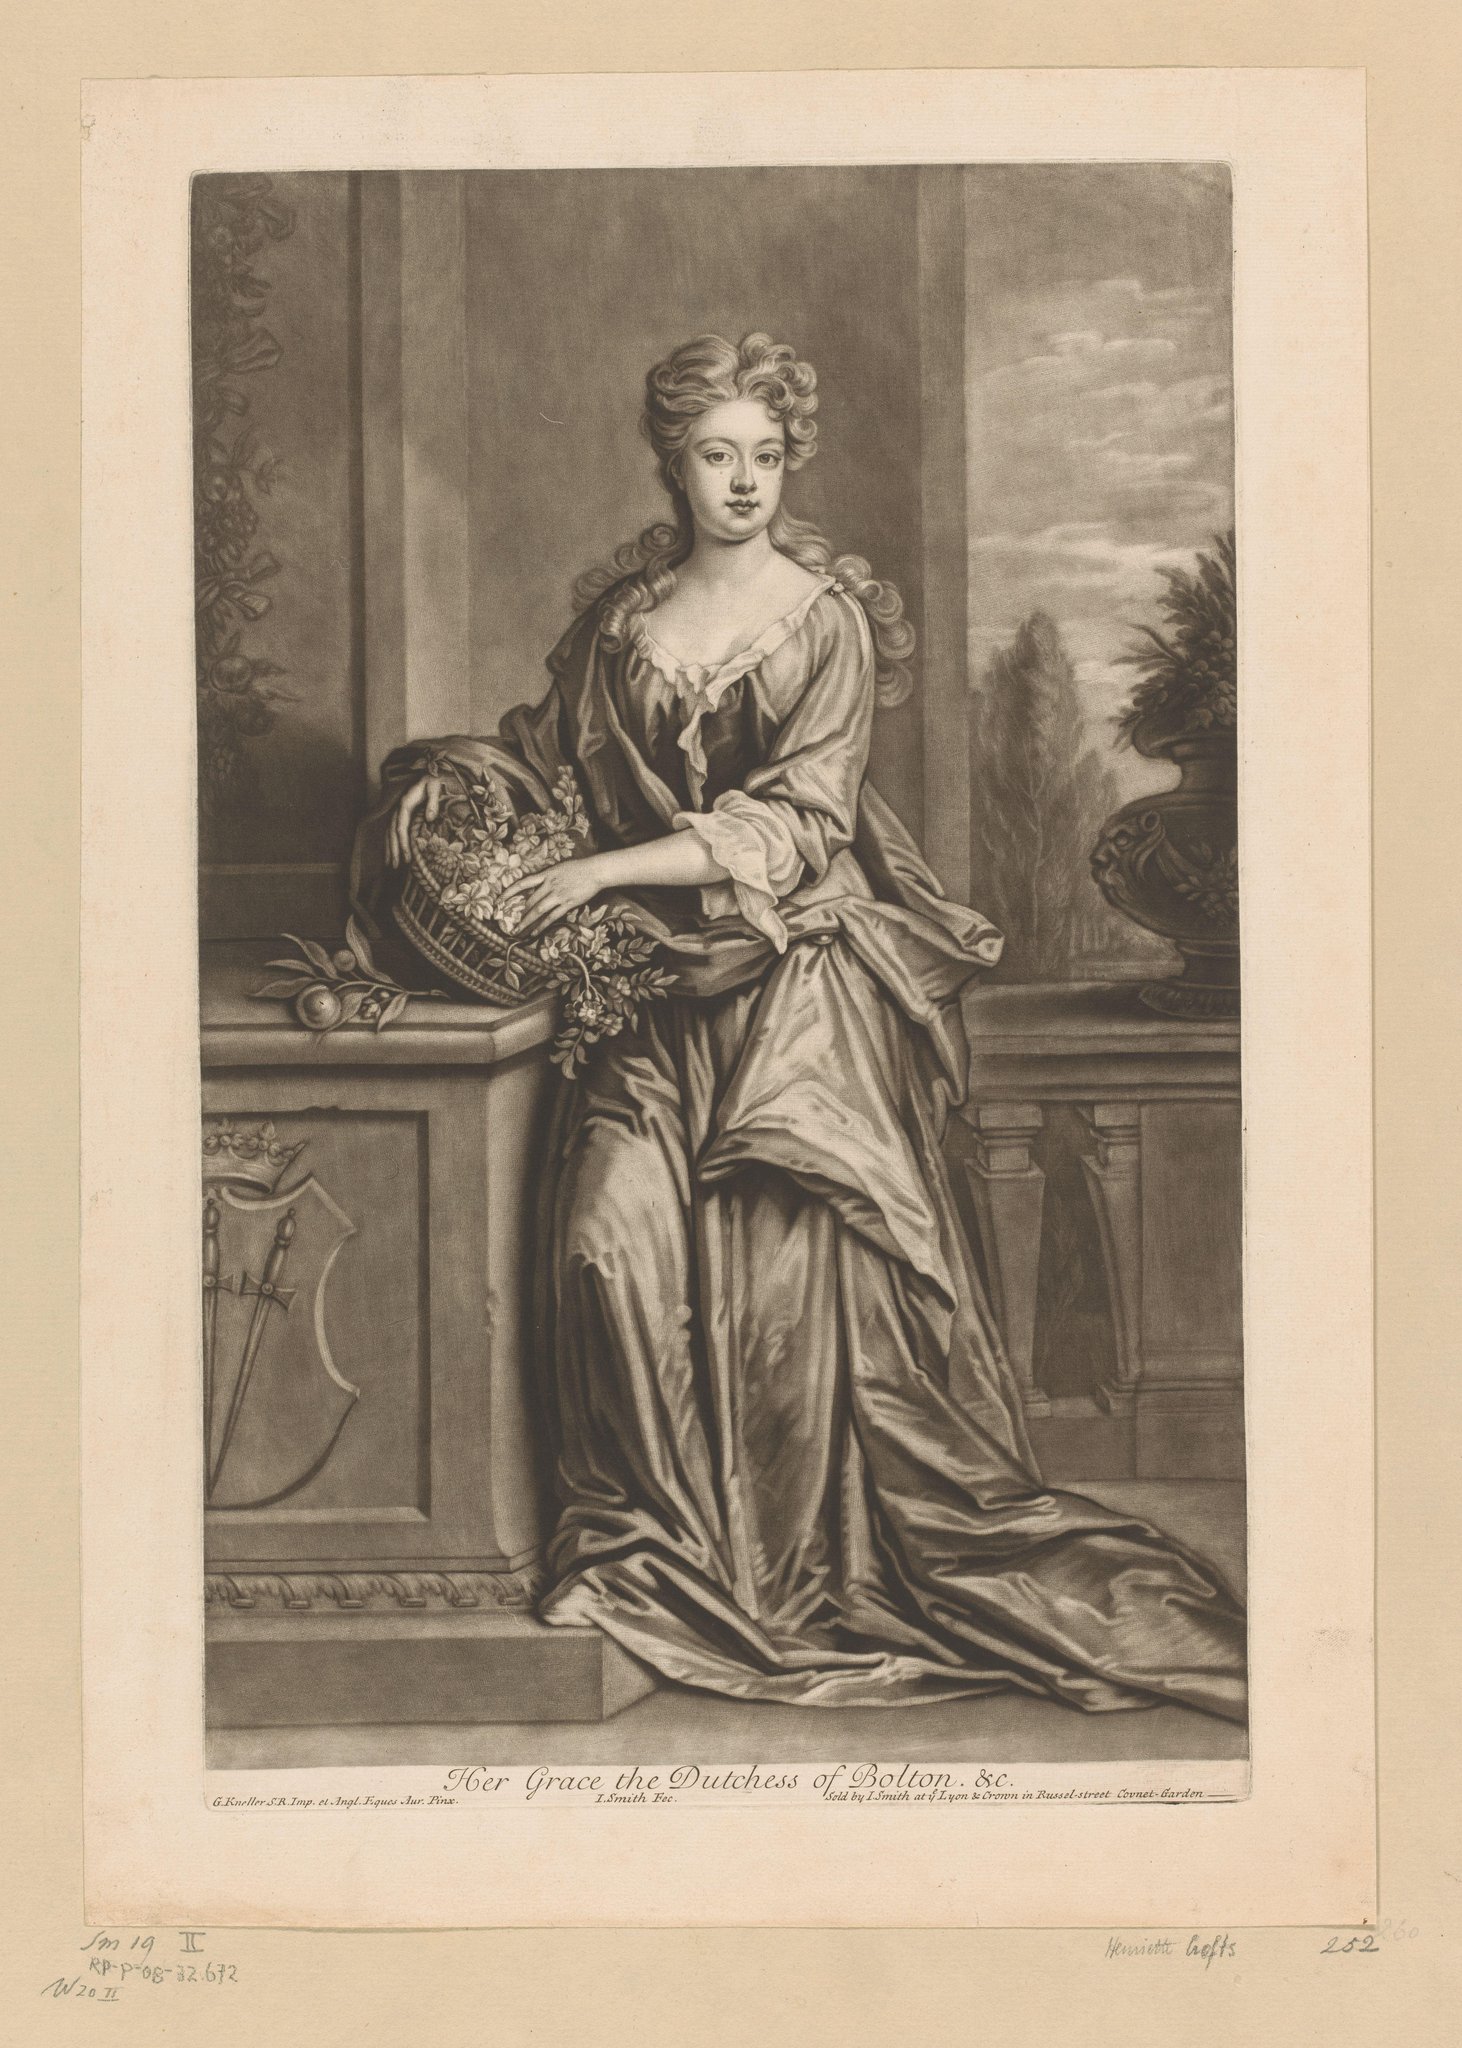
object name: print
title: Portret van Henrietta Paulet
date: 1692-1742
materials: paper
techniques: mezzotint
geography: london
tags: historical persons, container made of plant material other than wood: basket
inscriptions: collector's mark: Lugt 240